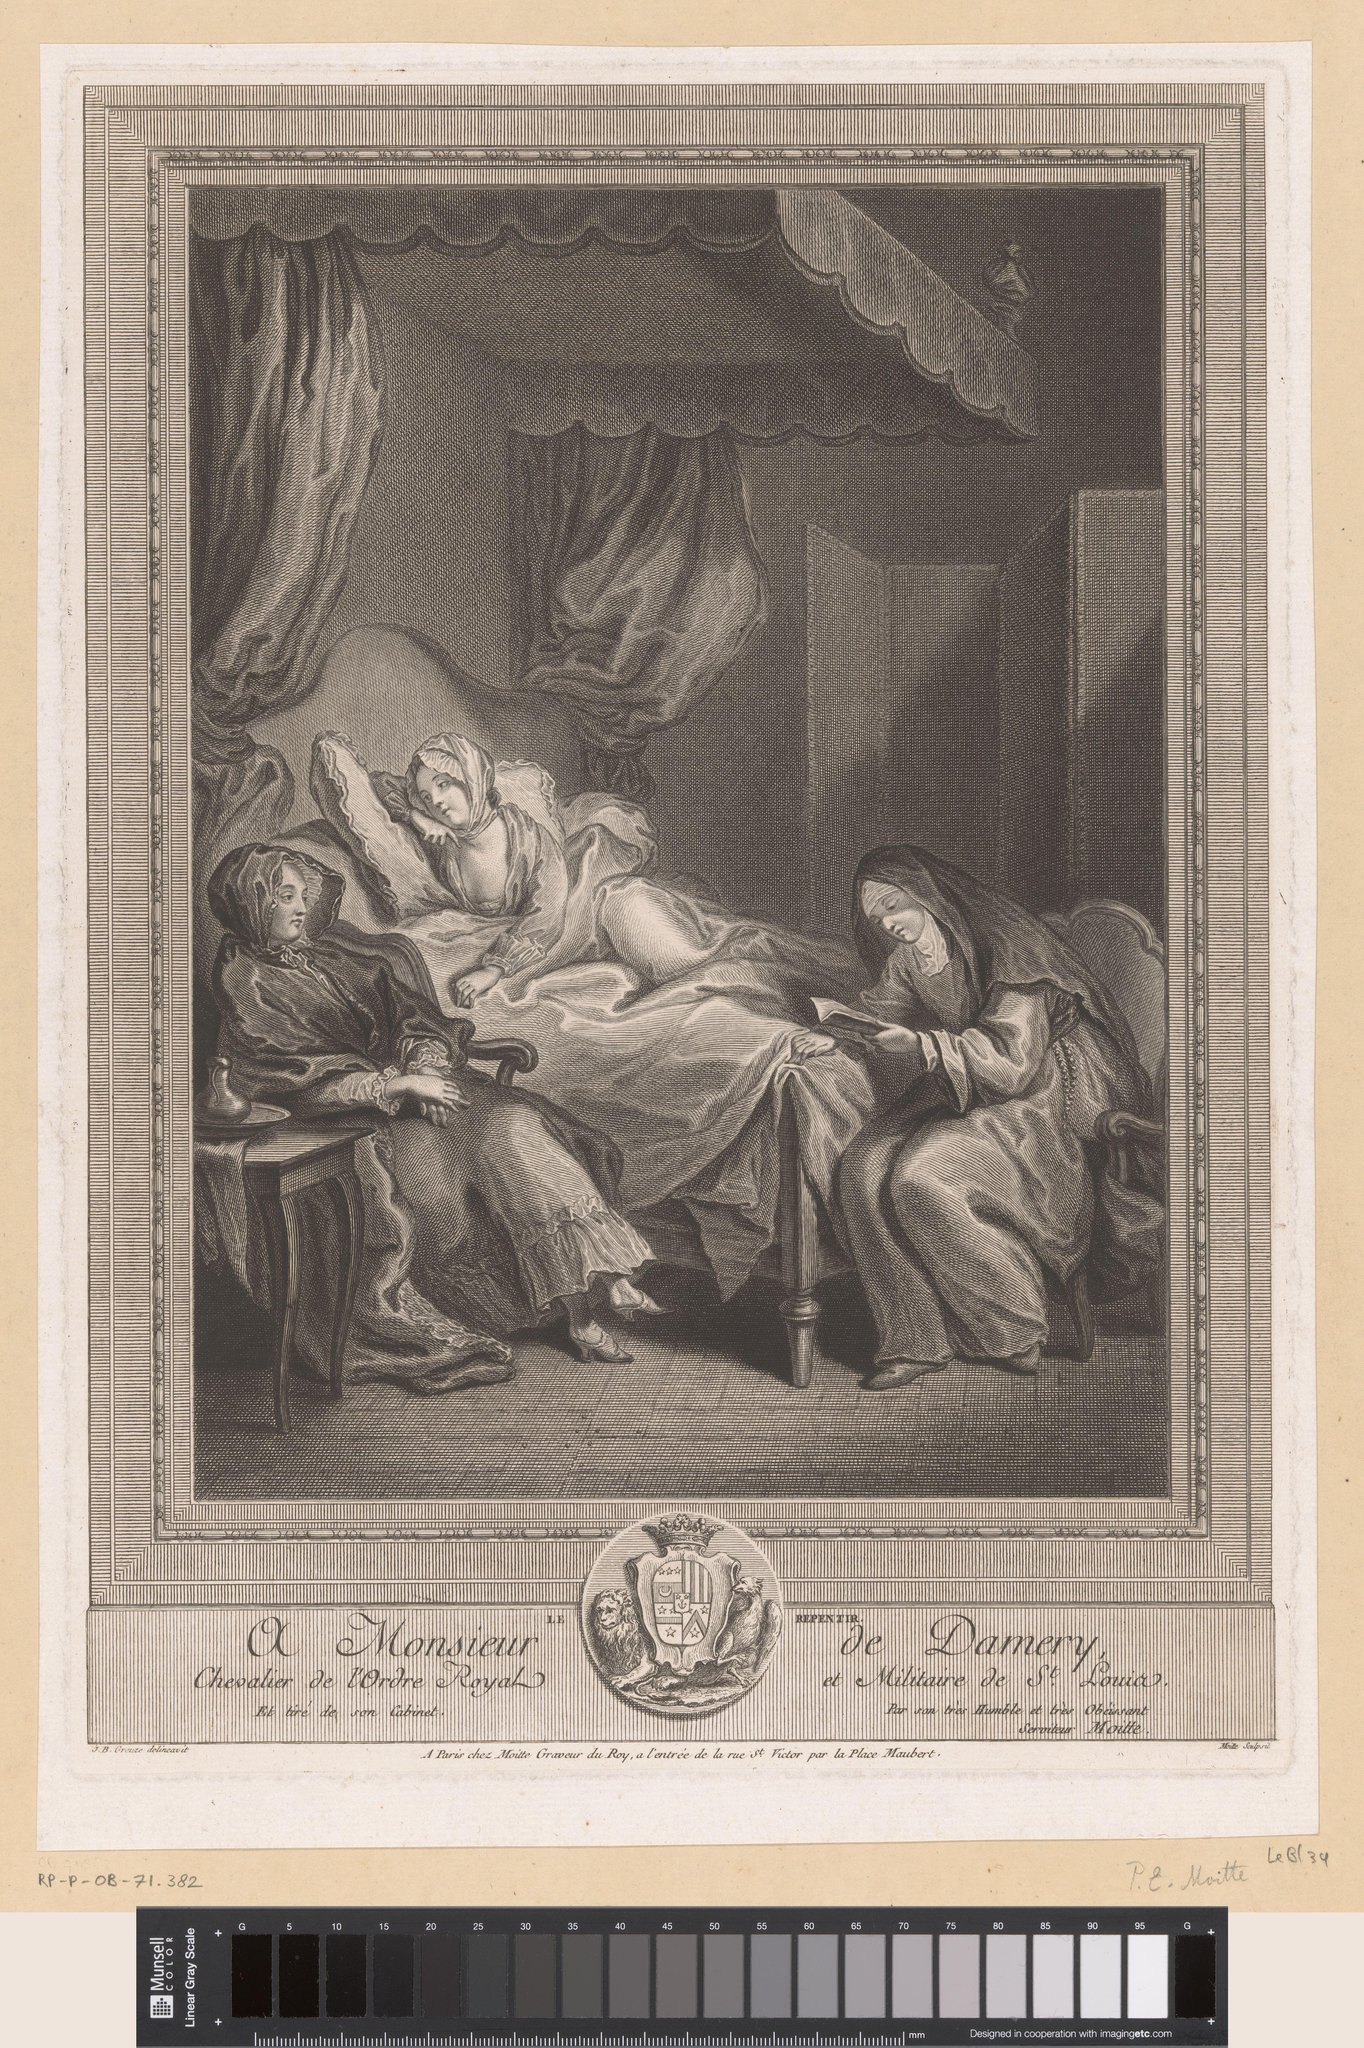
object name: print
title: Jonge vrouw in bed, naast haar een andere vrouw en non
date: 1732-1780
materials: paper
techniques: engraving, etching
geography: paris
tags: nun(s), bed, penance, 'poenitentia'; 'contritione' (ripa) ~ part of the confession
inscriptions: number: ‘No. 2450’